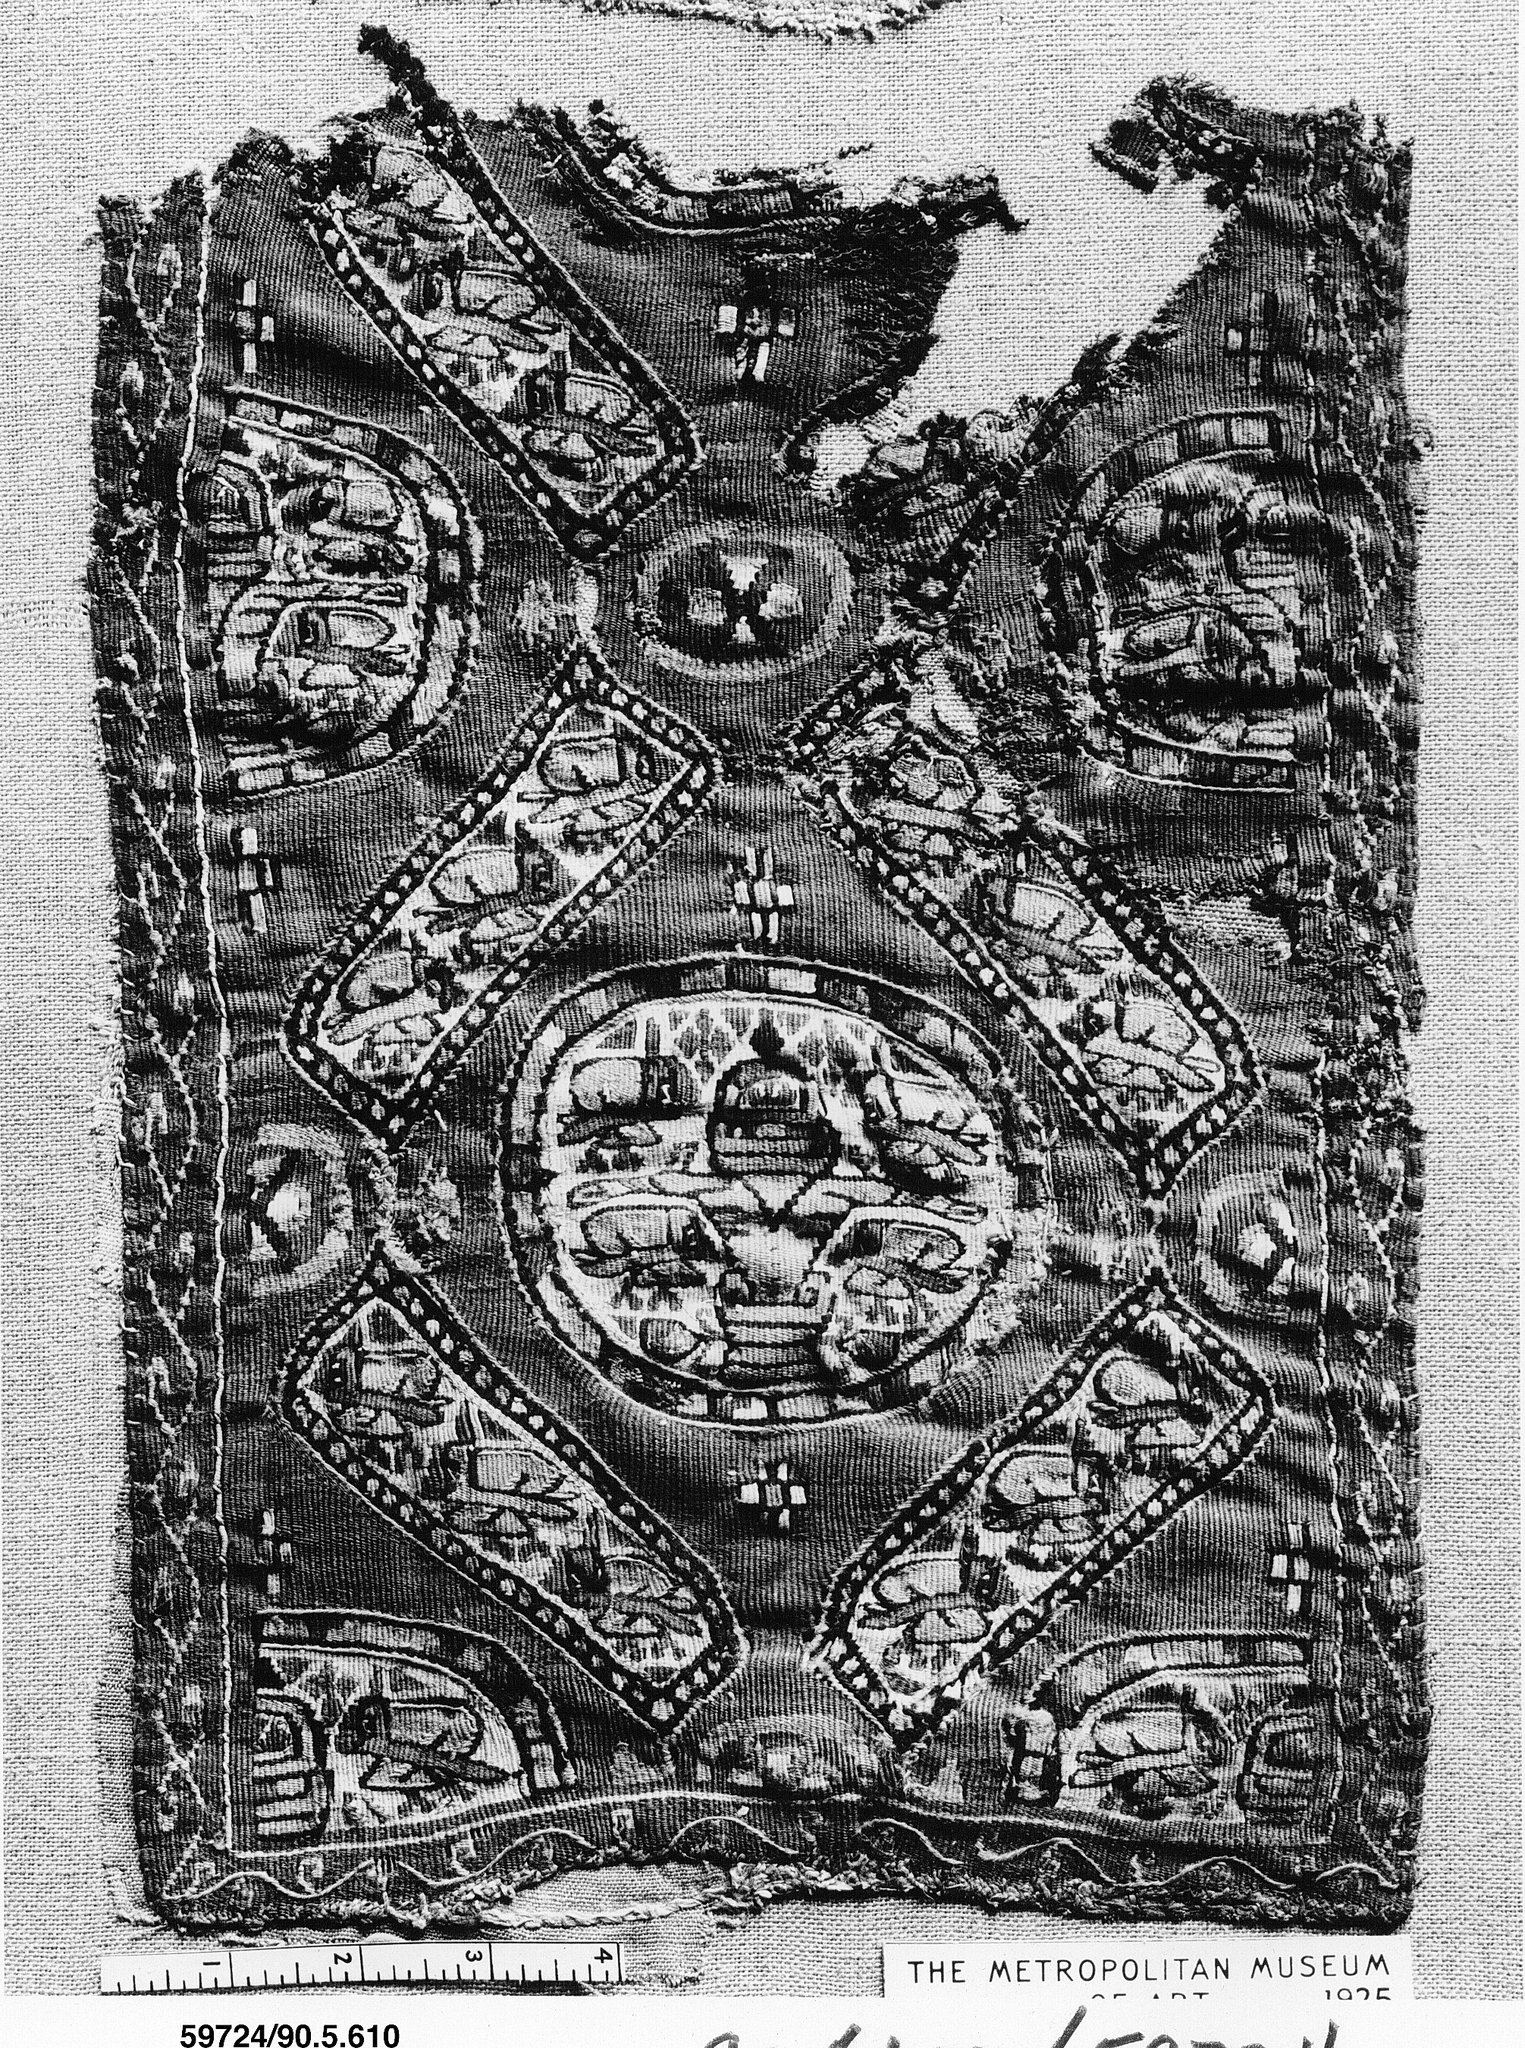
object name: textile fragment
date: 501-700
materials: linen, wool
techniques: weave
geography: egypt